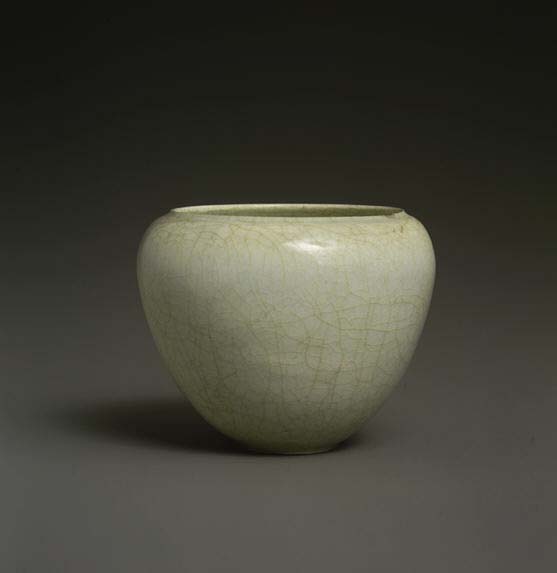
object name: jar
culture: chinese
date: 1001-1200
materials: stoneware